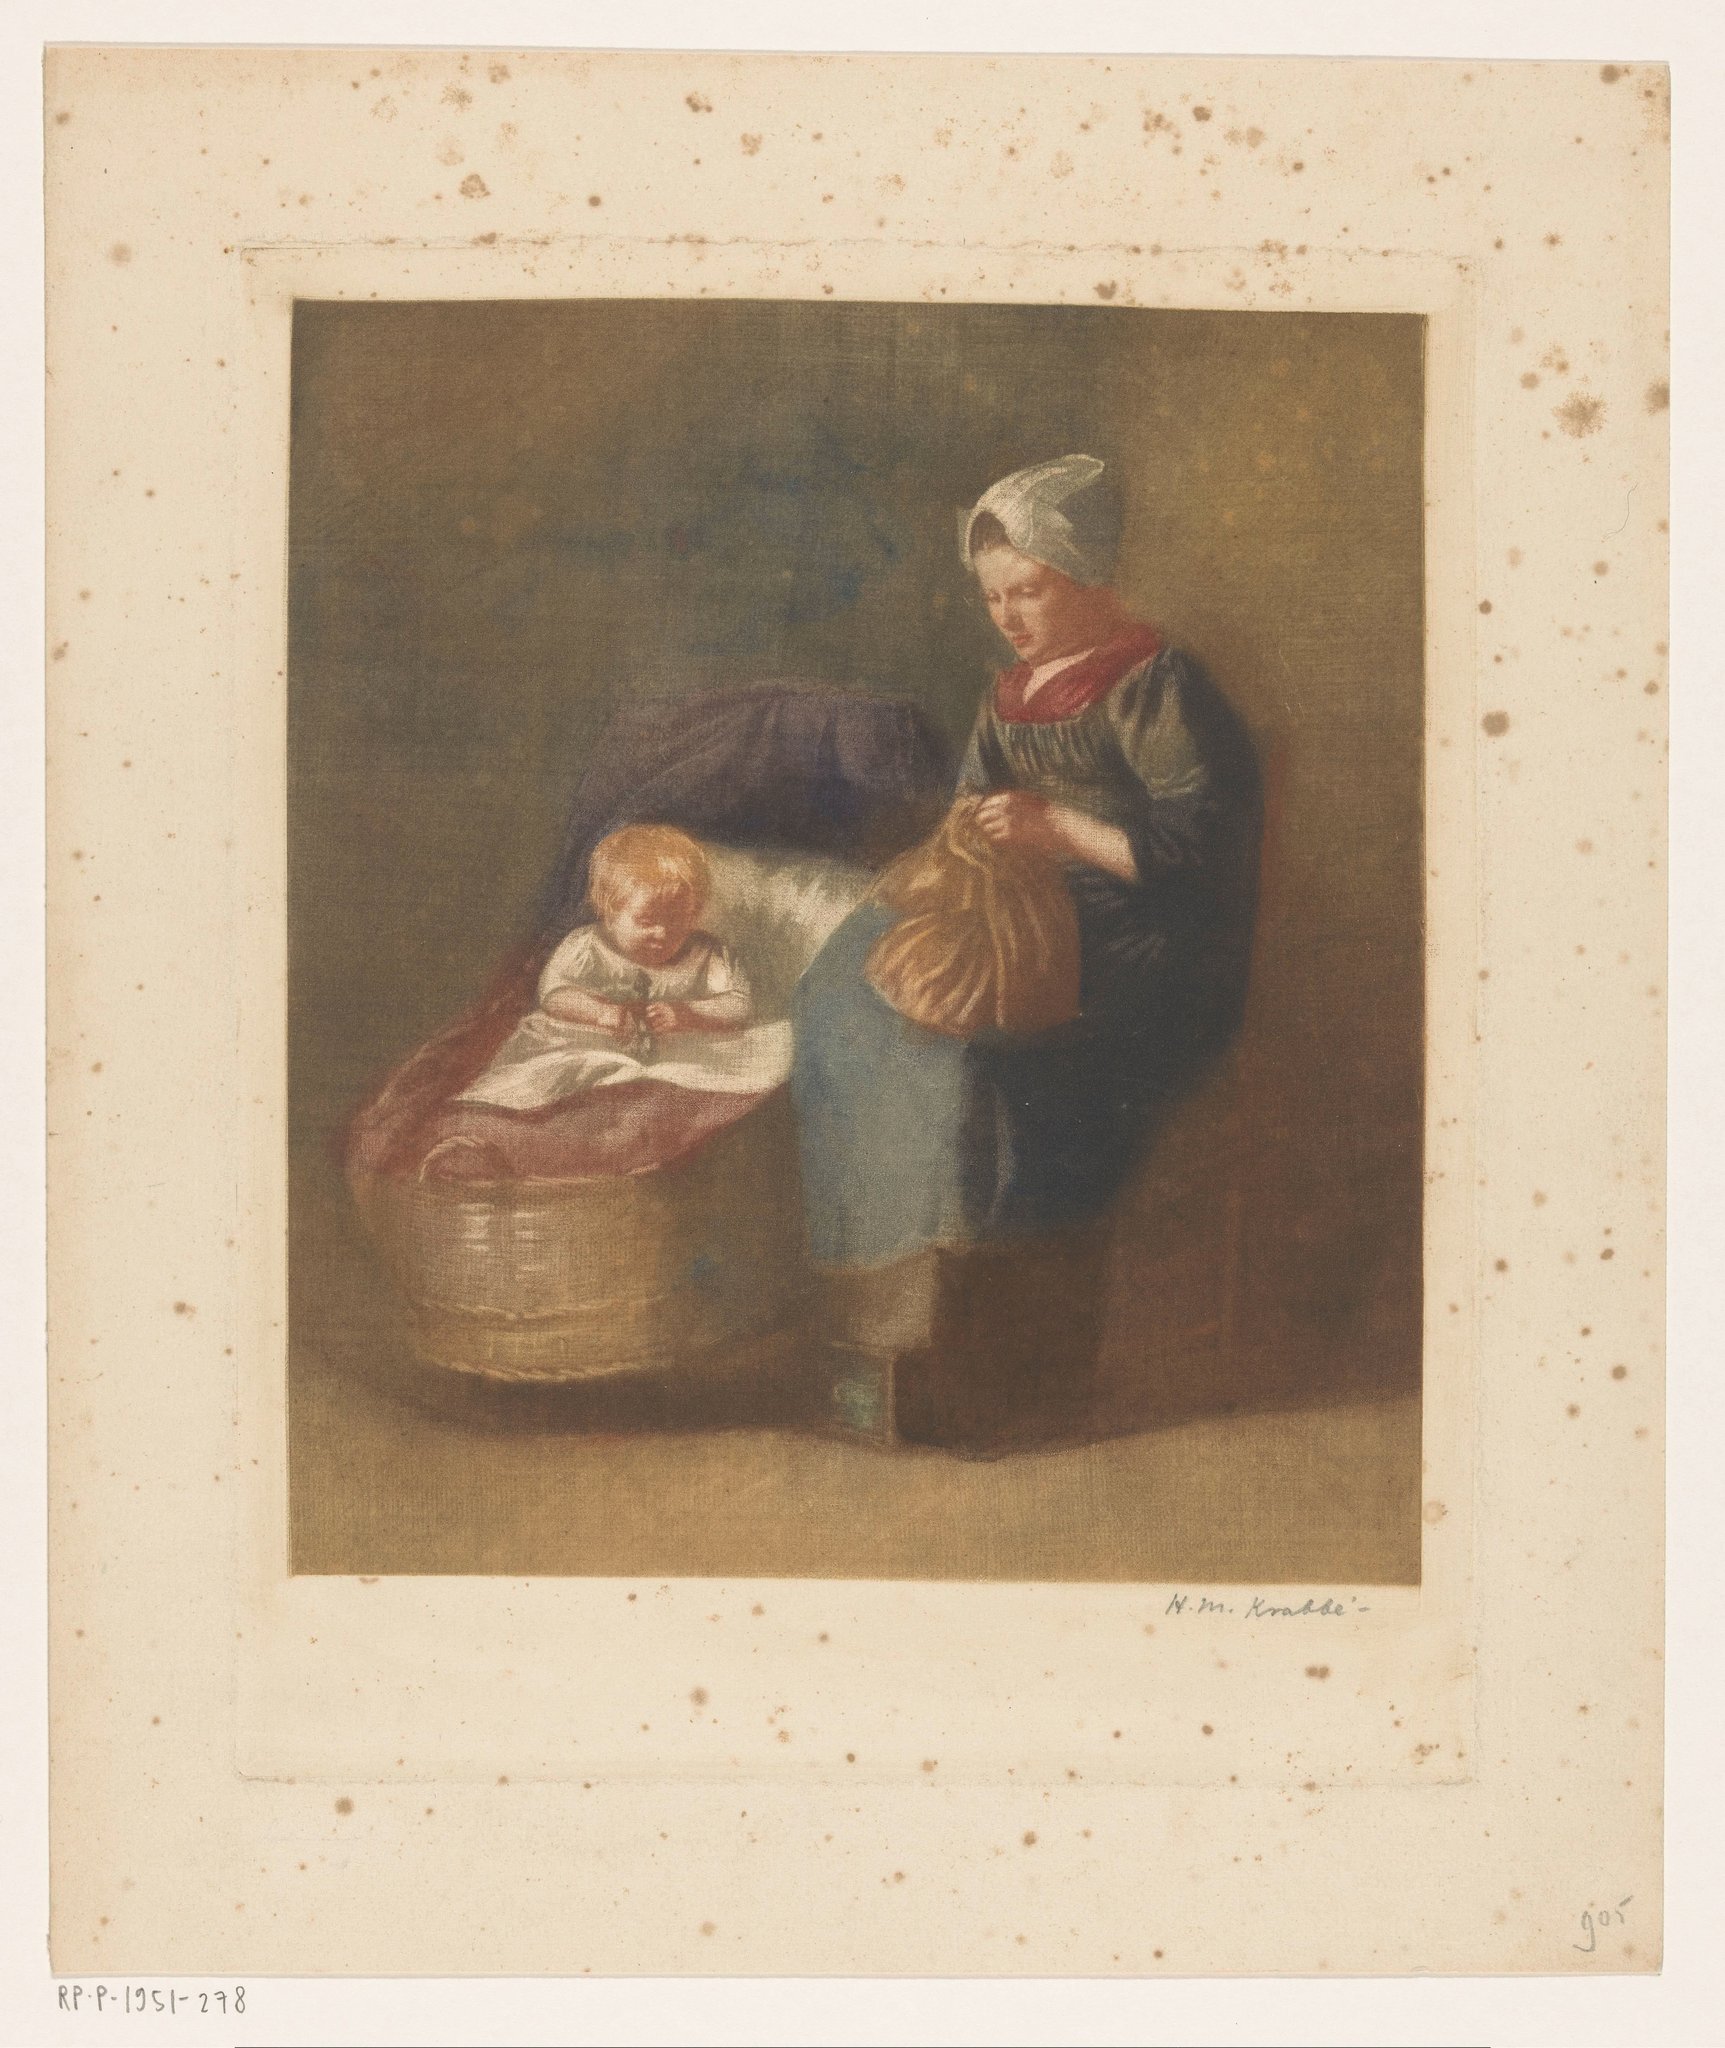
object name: print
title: Handwerkende vrouw naast een kind een wieg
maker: heinrich m. krabbé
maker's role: draughtsman, print maker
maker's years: 1868-1931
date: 1878-1931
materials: paper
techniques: color mezzotint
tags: cradle, crib, infant, baby, home sewing; repair of clothes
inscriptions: collector's mark: Lugt 2228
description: Het kind heeft een stuk speelgoed in handen.